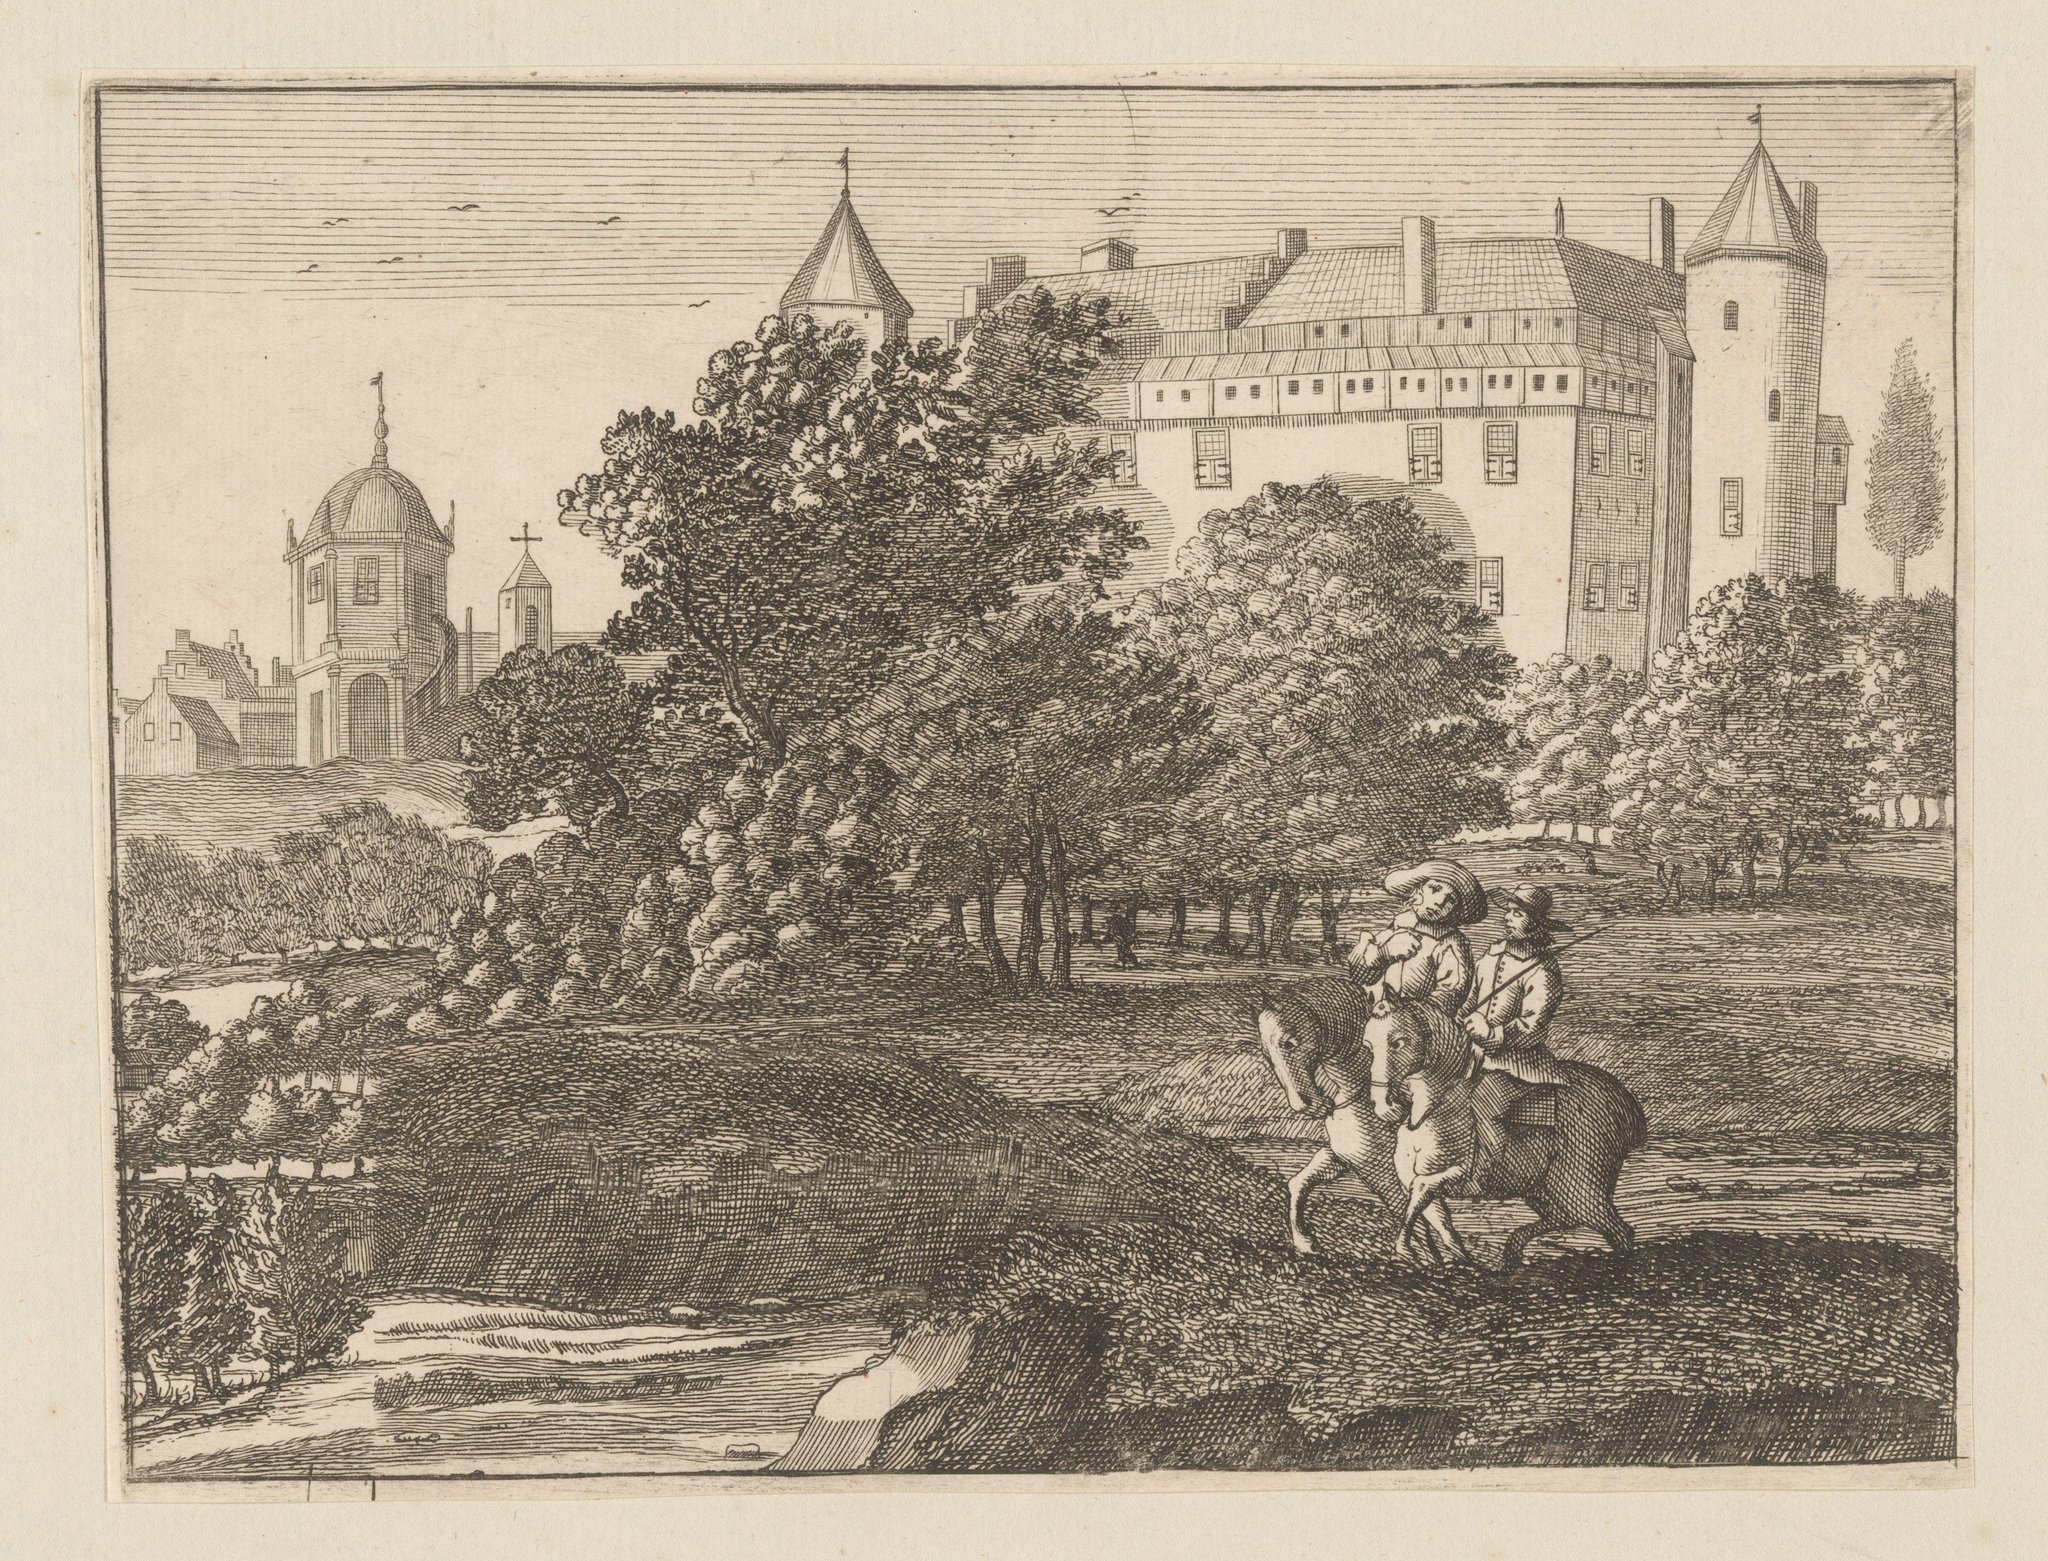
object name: print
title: Gezicht op kasteel De Haar in Haarzuilens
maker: Anonymous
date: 1650-1750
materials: paper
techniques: etching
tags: castle